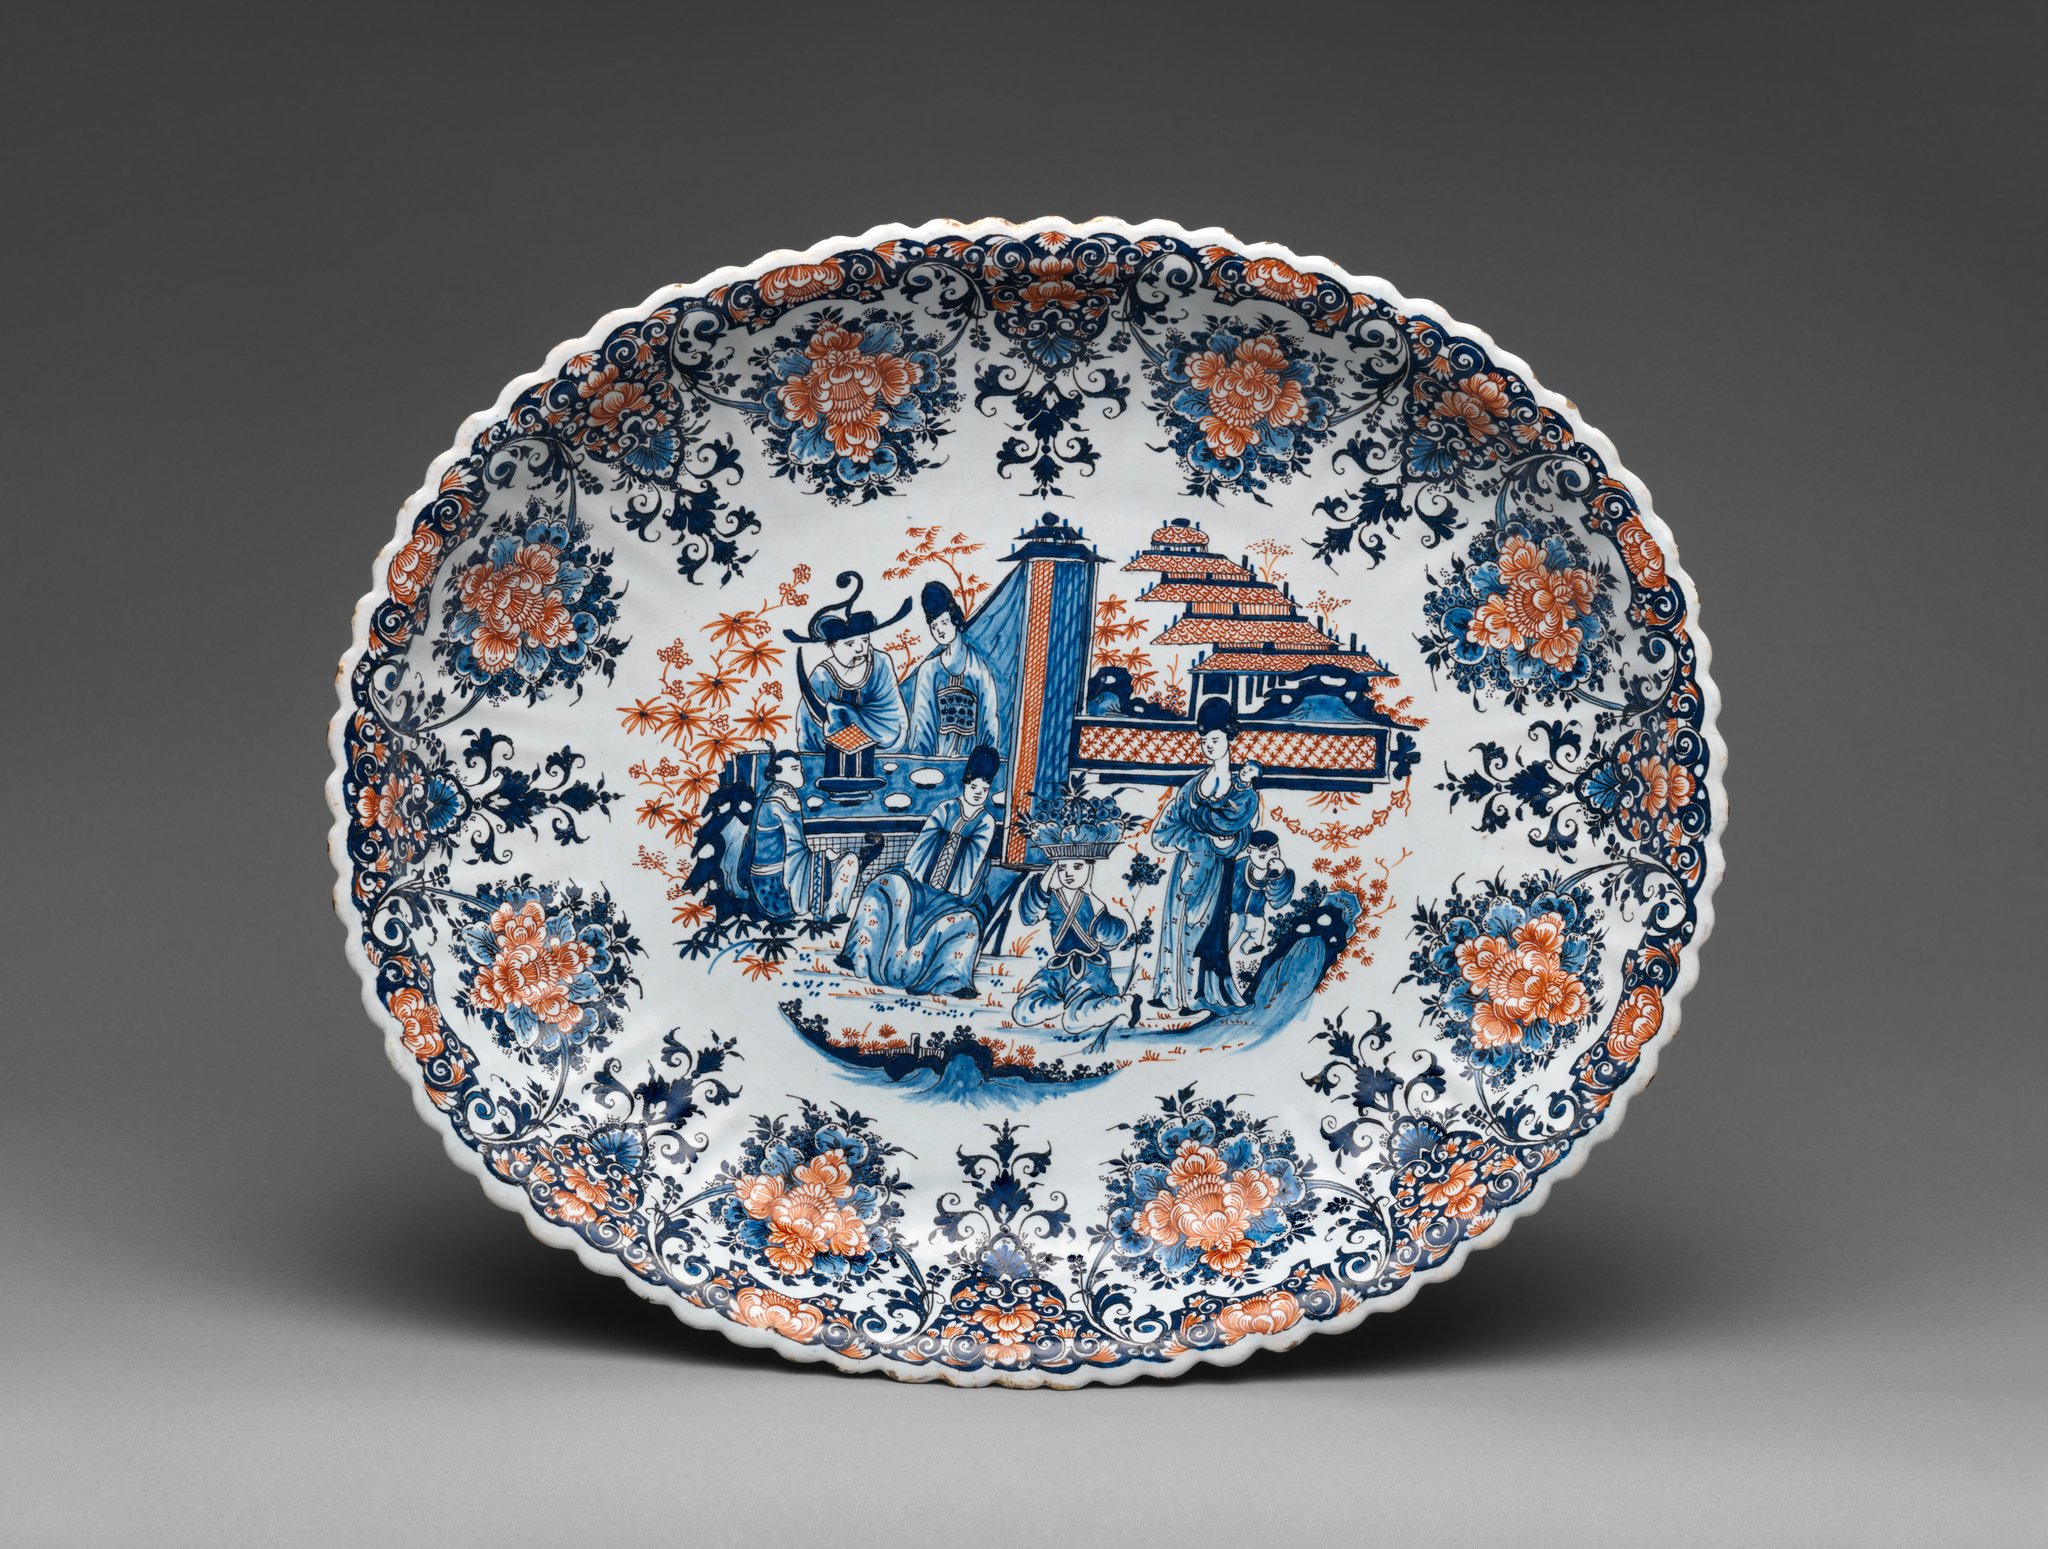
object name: plateau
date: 1720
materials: faience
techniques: glazing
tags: chinoiserie,children,men,women